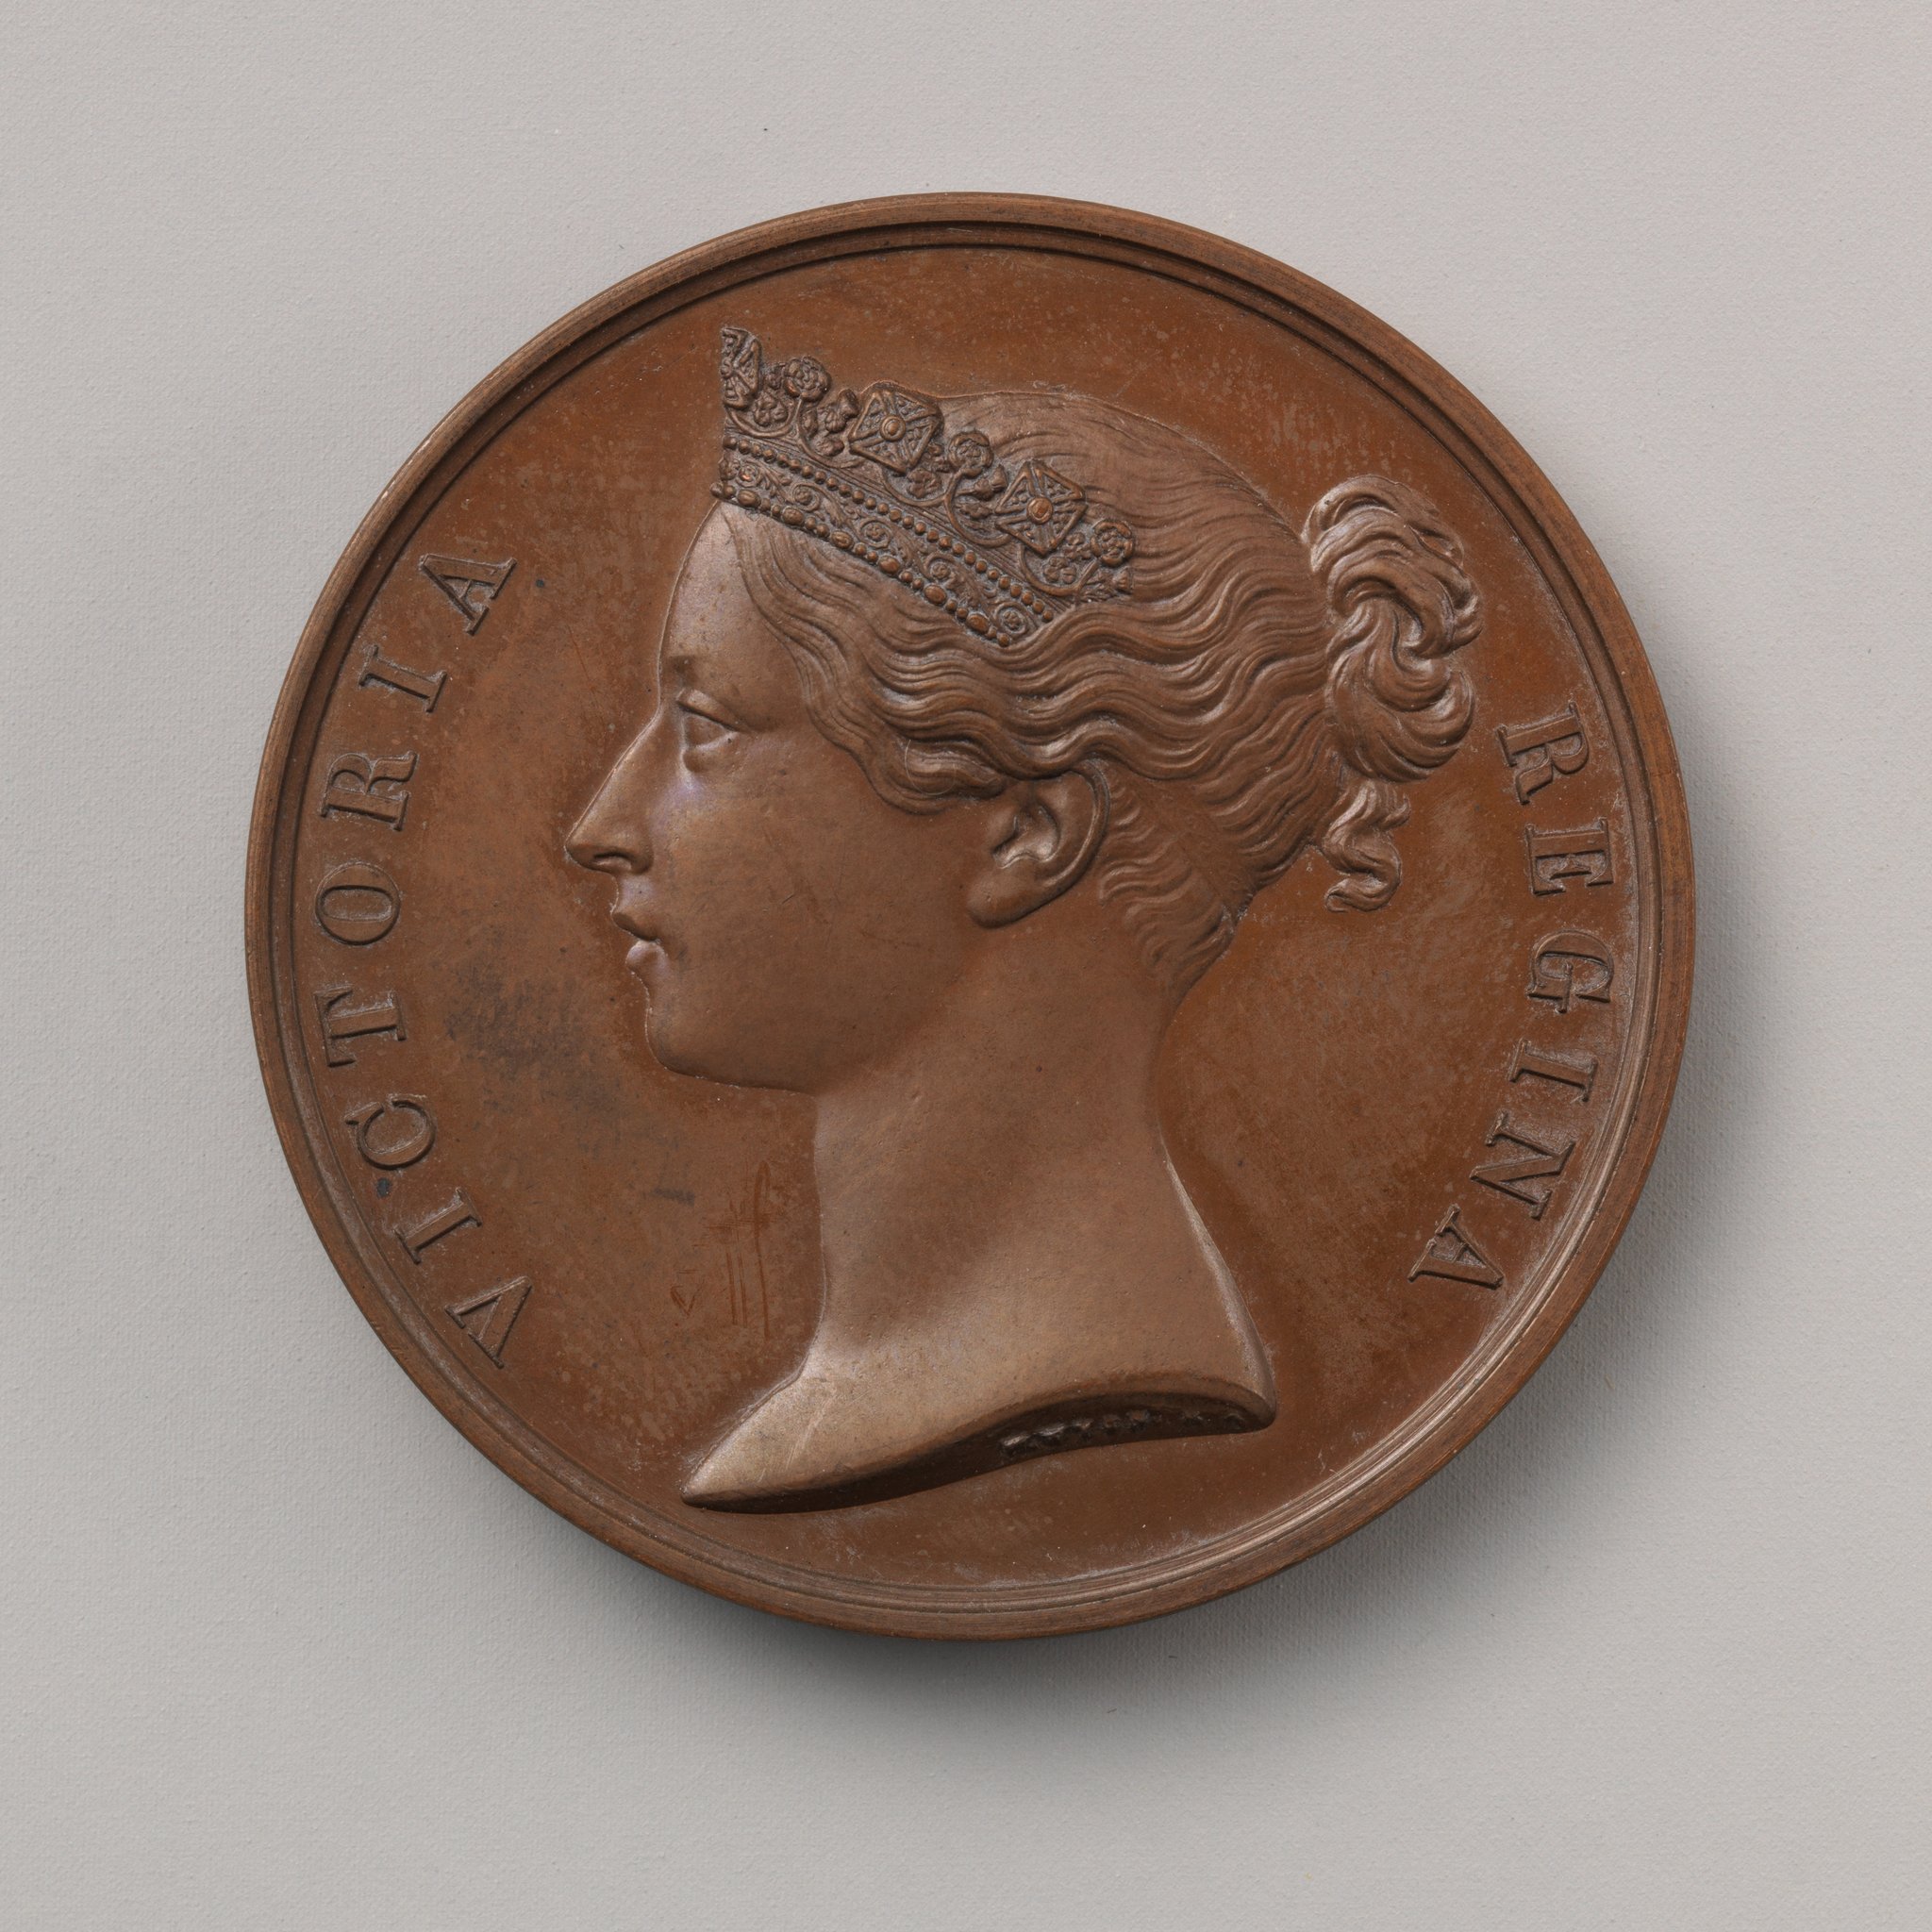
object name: medal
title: The Mutiny Medal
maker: william wyon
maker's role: artist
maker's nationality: british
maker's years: 1795-1851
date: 1858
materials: bronze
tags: profiles,women